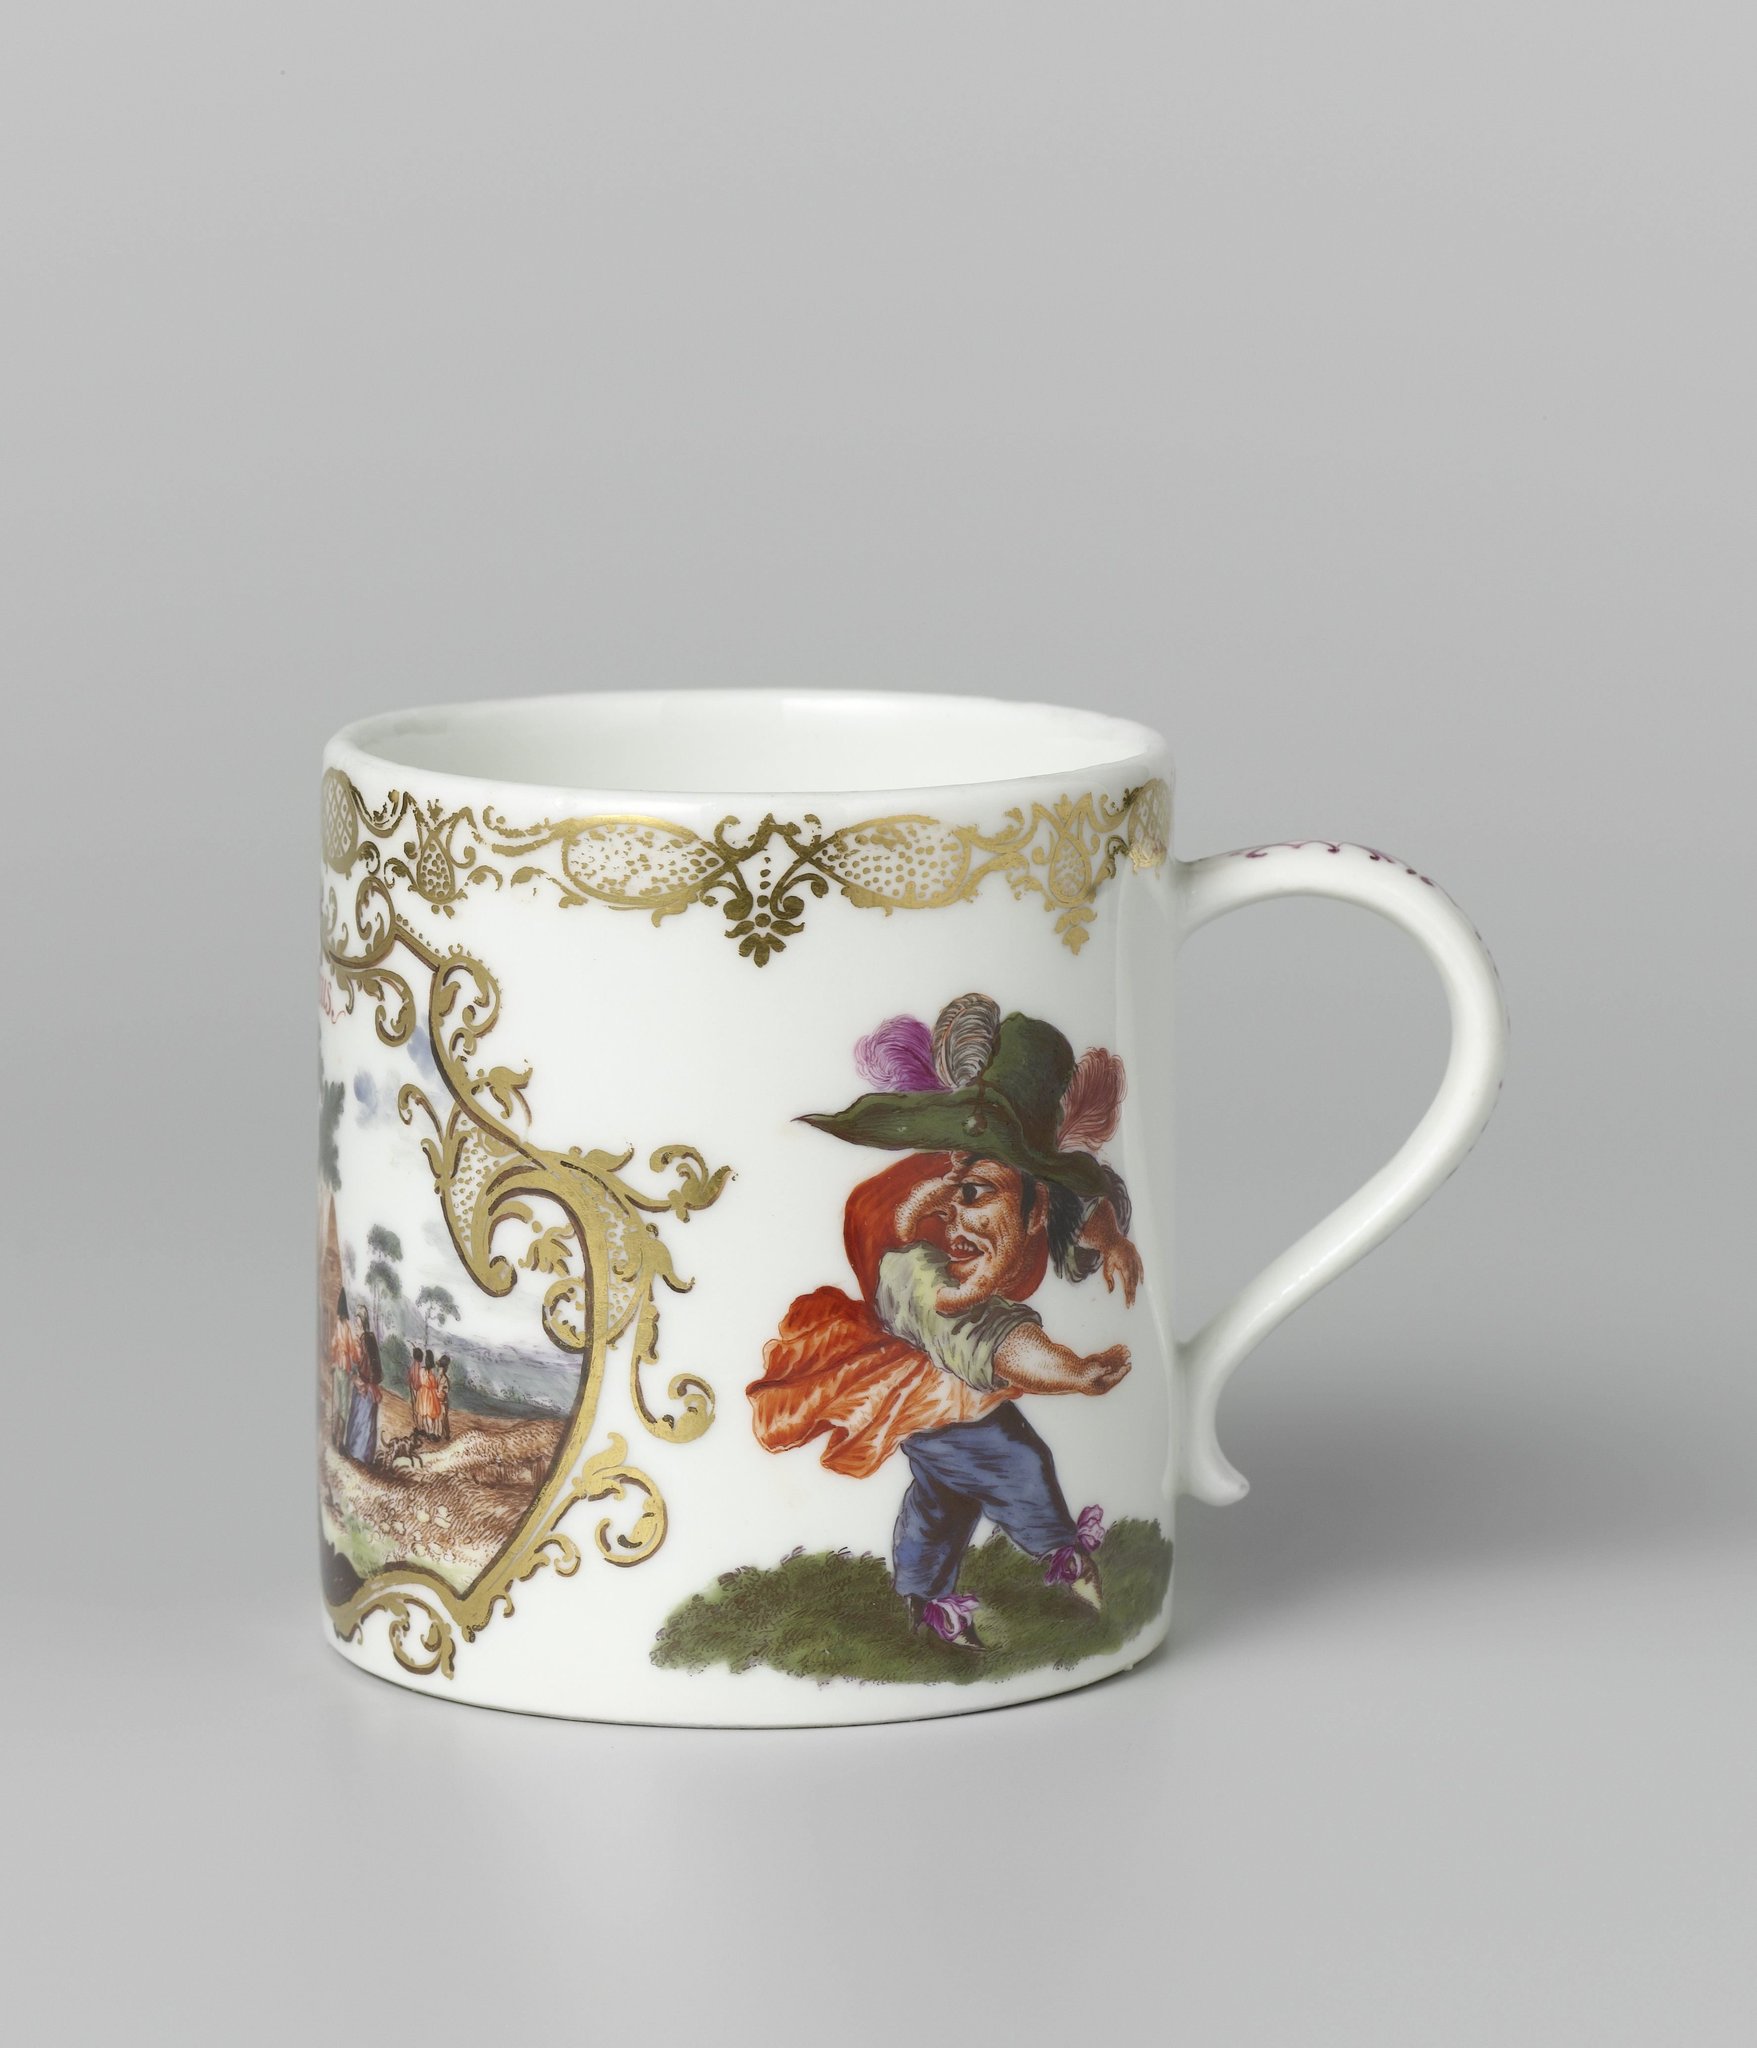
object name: eating drinking utensil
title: Beker met oor, veelkleurig beschilderd met een voorstelling van de maand maart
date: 1740-1745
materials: porcelain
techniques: painted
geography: meissen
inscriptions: factory mark, mark: ‘No: 1.’, mold mark: ‘24’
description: Twelve beakers. Porcelain. Meissen, c. 1740 - 1745.